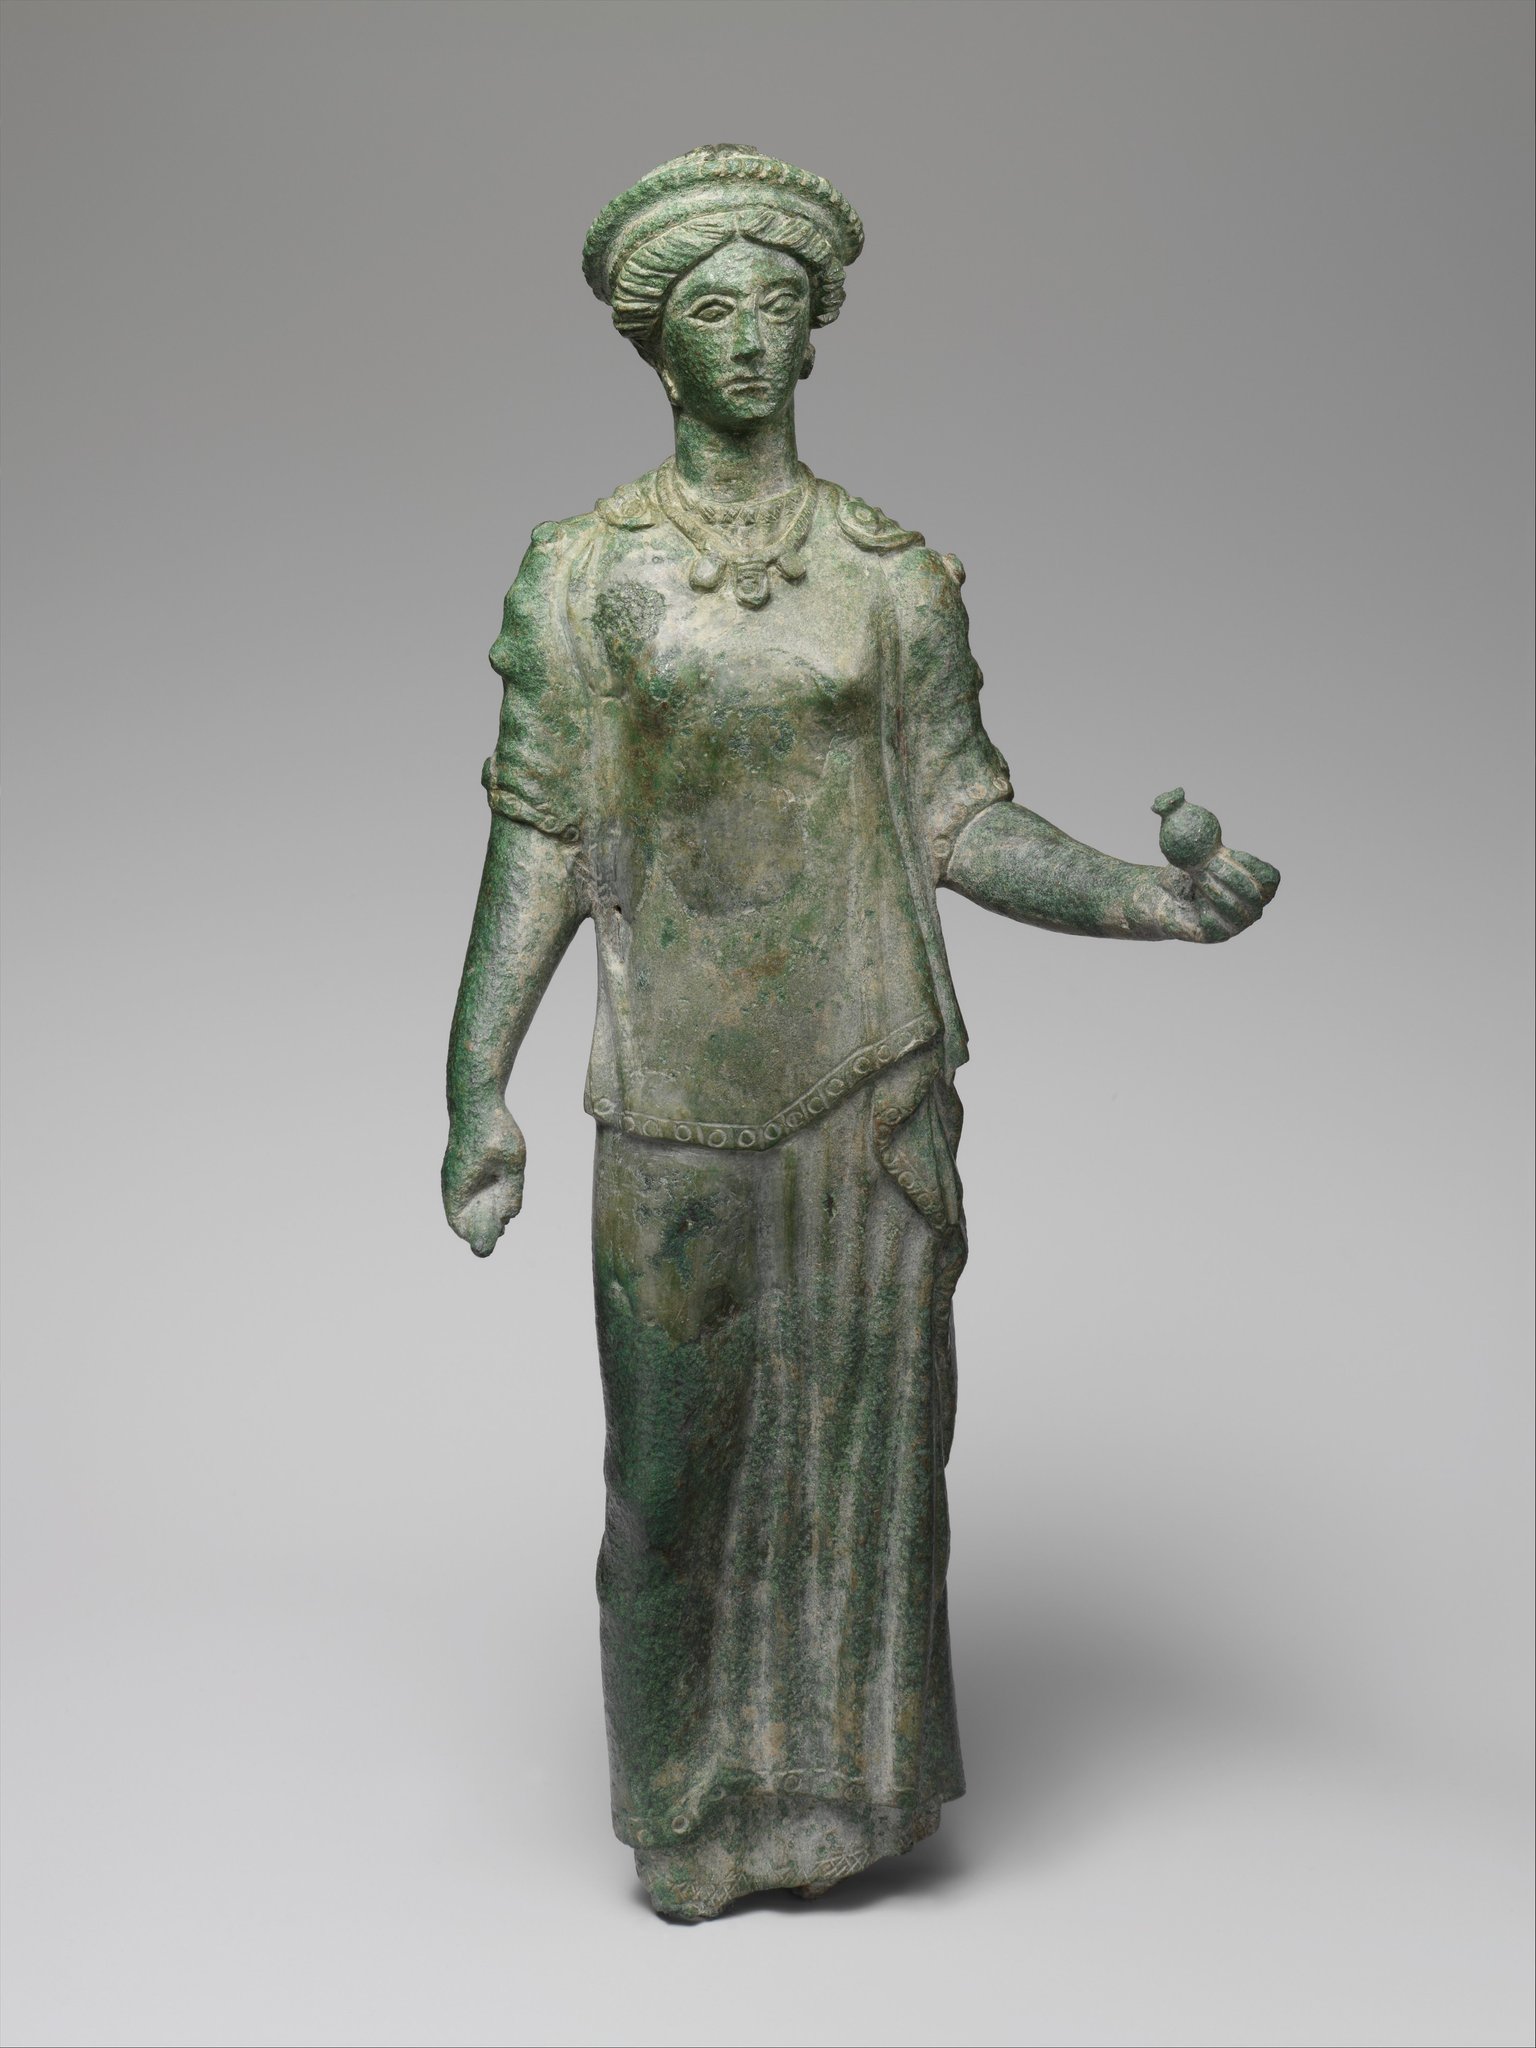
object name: statuette of a woman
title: Bronze statuette of a female votary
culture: etruscan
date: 400-201 BCE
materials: bronze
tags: diadems,necklaces,pomegranates,women